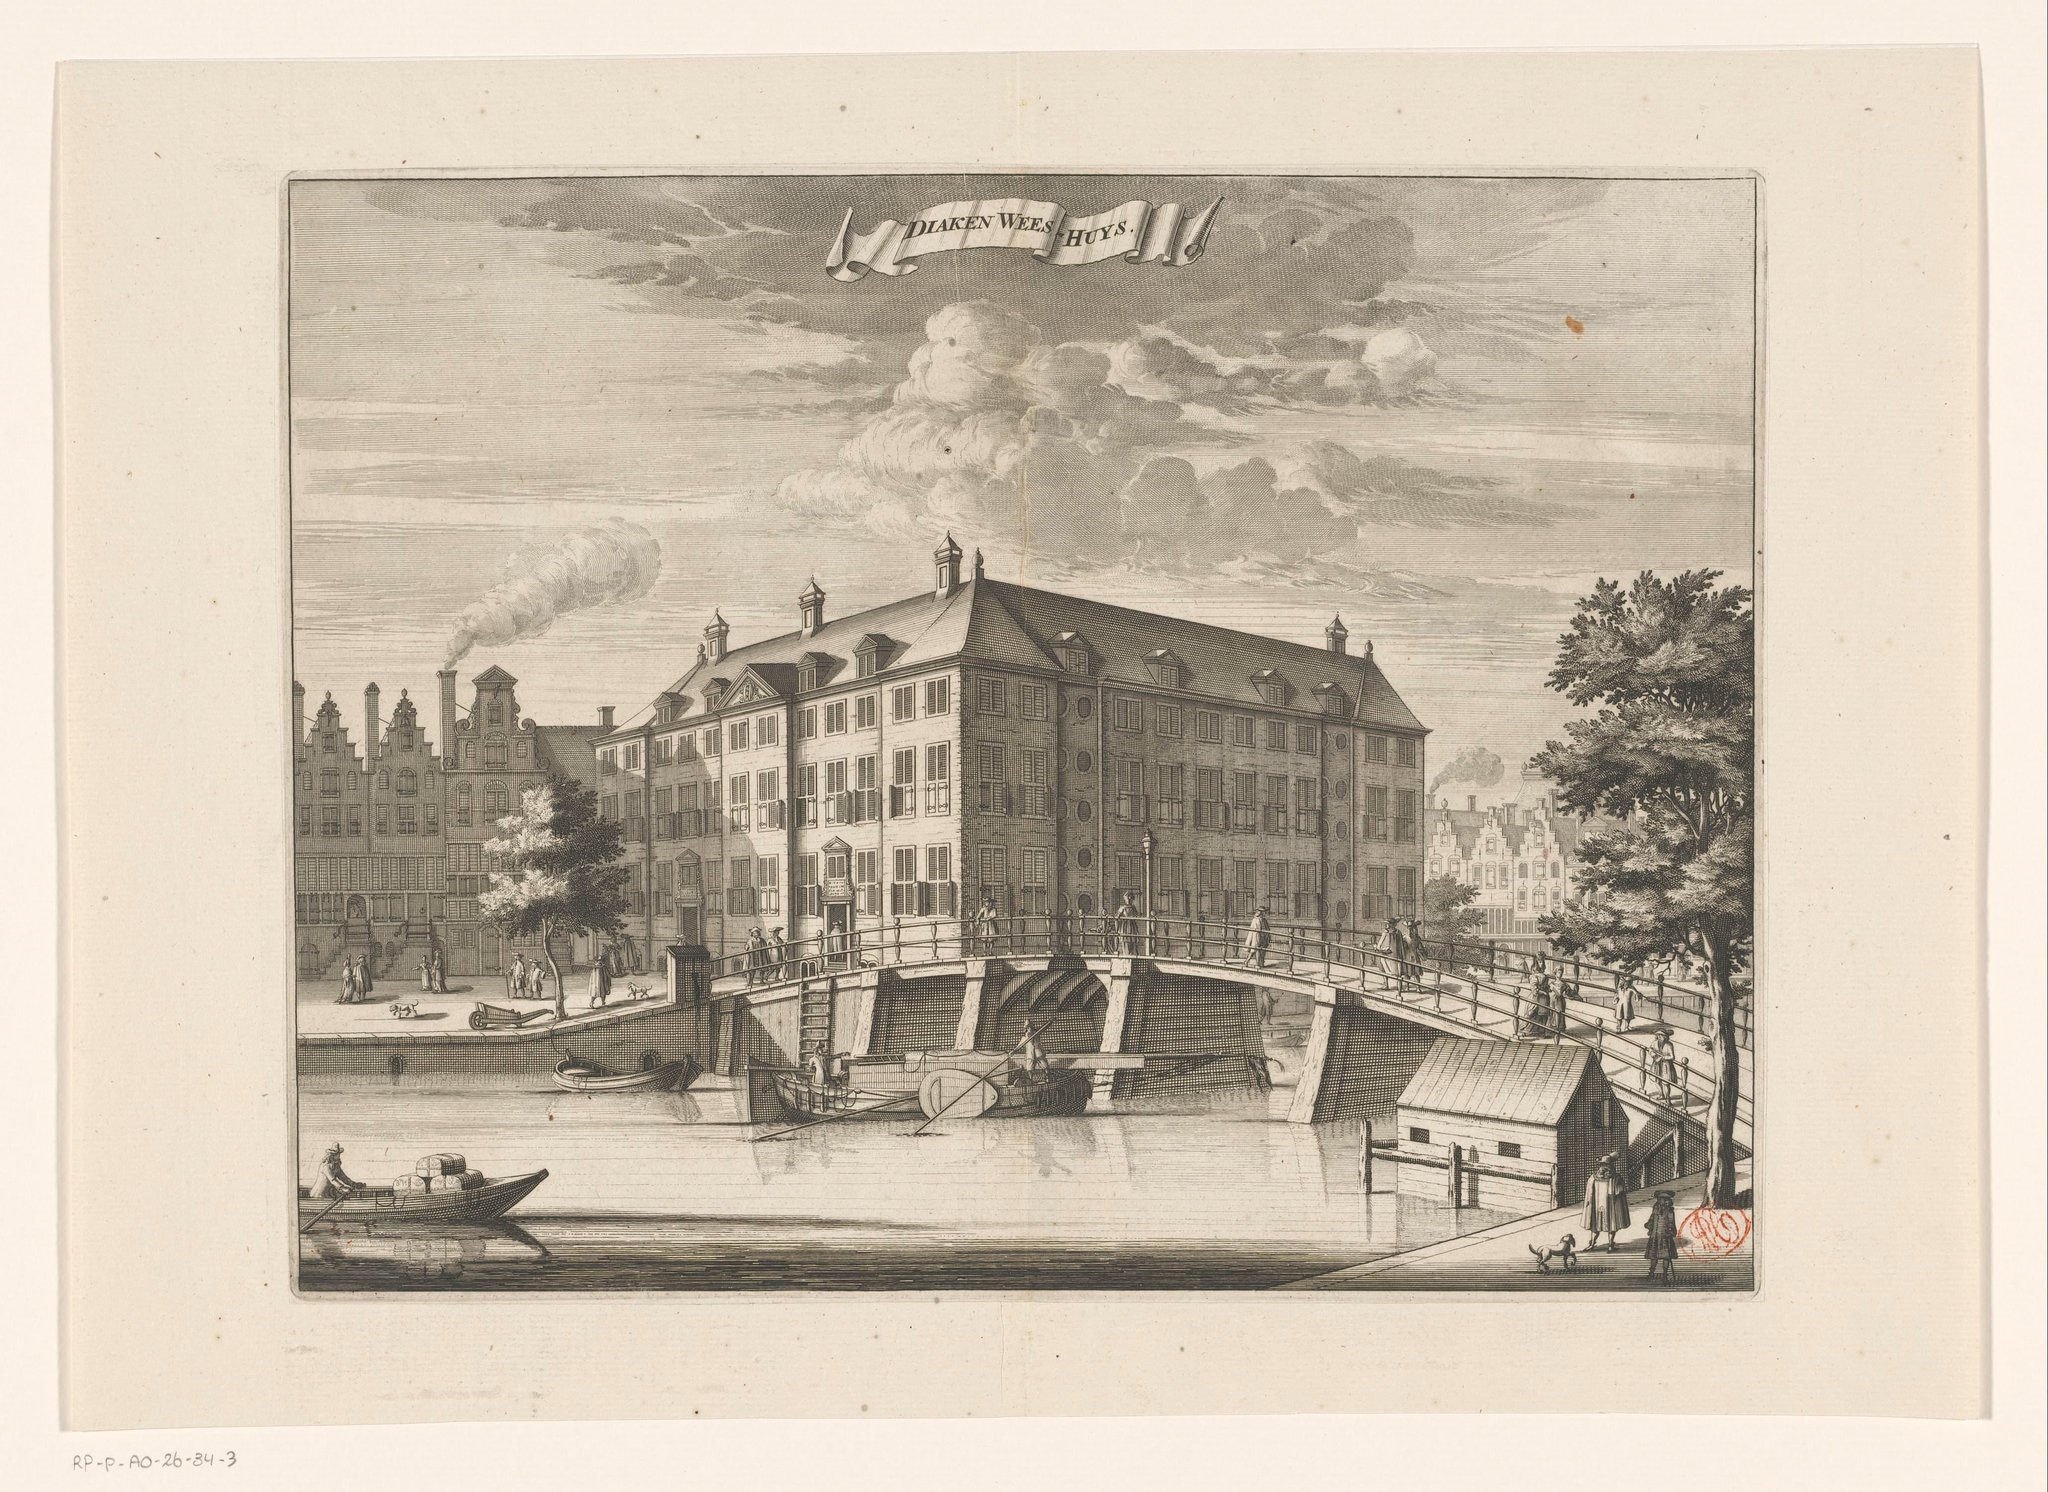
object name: book illustration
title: Gezicht op het Diaconieweeshuis te Amsterdam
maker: Anonymous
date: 1693-1694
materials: paper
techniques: engraving, etching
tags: bridge in city across river, canal, etc. (+ city(-scape) with figures, staffage), public welfare, orphanage, canals, waters (in city) (+ city(-scape) with figures, staffage), street (+ city(-scape) with figures, staffage)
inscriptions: collector's mark: Lugt 195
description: Huidige staat van prent ook gebruikt in: Commelin, Caspar. Beschryvinge van Amsterdam, desselfs eerste oorspronk uyt den Huyse (…). 2 delen. Amsterdam: Abraham Wolfgang, Gillis Janssonius van Waesberge, Johannes Janssonius van Waesberge II, weduwe Dirk Boom I, Hendrick Boom en Rembertus Goethals, 1693. En in: Commelin, Caspar. Beschryvinge van Amsterdam, zynde een naukeurige verhandelinge van desselfs eerste oorspronk uyt (…). 2 delen. Amsterdam: weduwe Aart Dircksz Oossaan, 1694. Latere staat ook gebruikt in: Commelin, Caspar. Beschryvinge van Amsterdam, zynde een naukeurige verhandelinge van desselfs eerste oorspronk uyt (…). 2 delen. 2e druk. Amsterdam: Andries van Damme, Johannes Ratelband, weduwe A. van Aaltwyk en Hermanus Uytwerf, 1726.